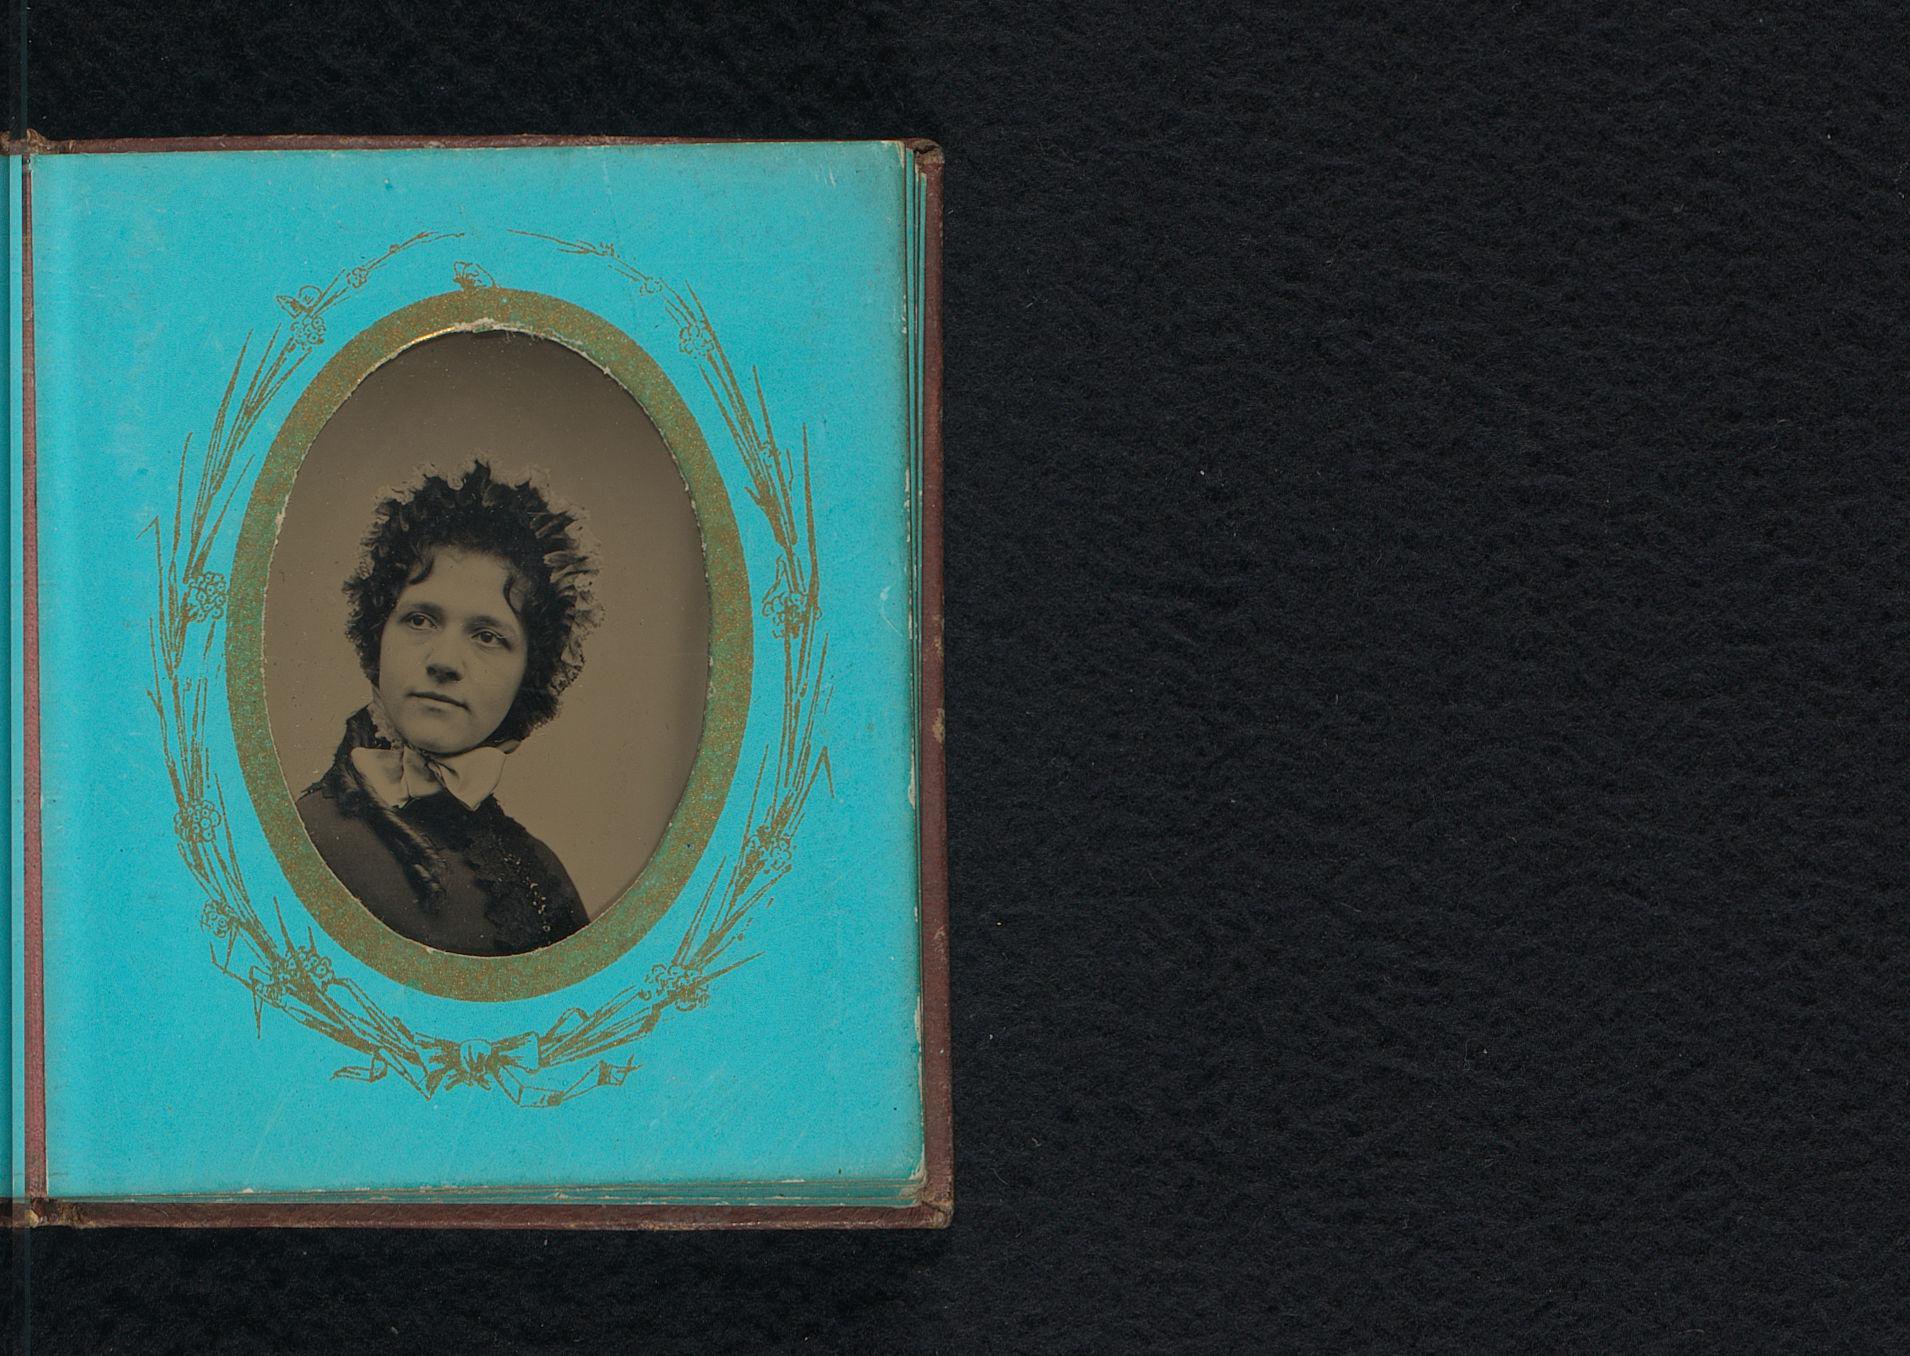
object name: album leaf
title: Portret van een vrouw met muts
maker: Anonymous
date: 1880-1900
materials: iron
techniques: ferrotyping, hand coloring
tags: historical persons not known by name - bb - woman, head-gear: cap